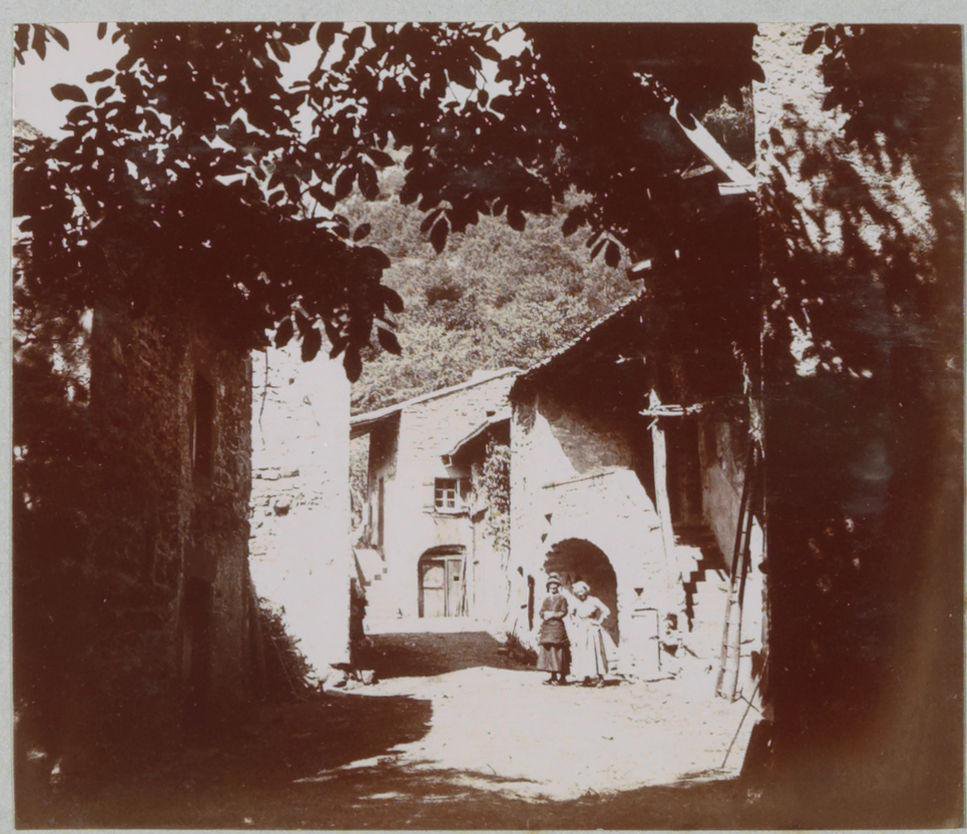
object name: photograph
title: Twee vrouwen in een straat in Enval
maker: delizy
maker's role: manufacturer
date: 1904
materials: paper, photographic support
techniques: gelatin silver print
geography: enval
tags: village street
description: Onderdeel van Fotoalbum van een Franse amateurfotograaf met opnames van uitstapjes in Frankrijk, Spanje, België, Luxemburg en Nederland, de eerste automobielen en autoraces.